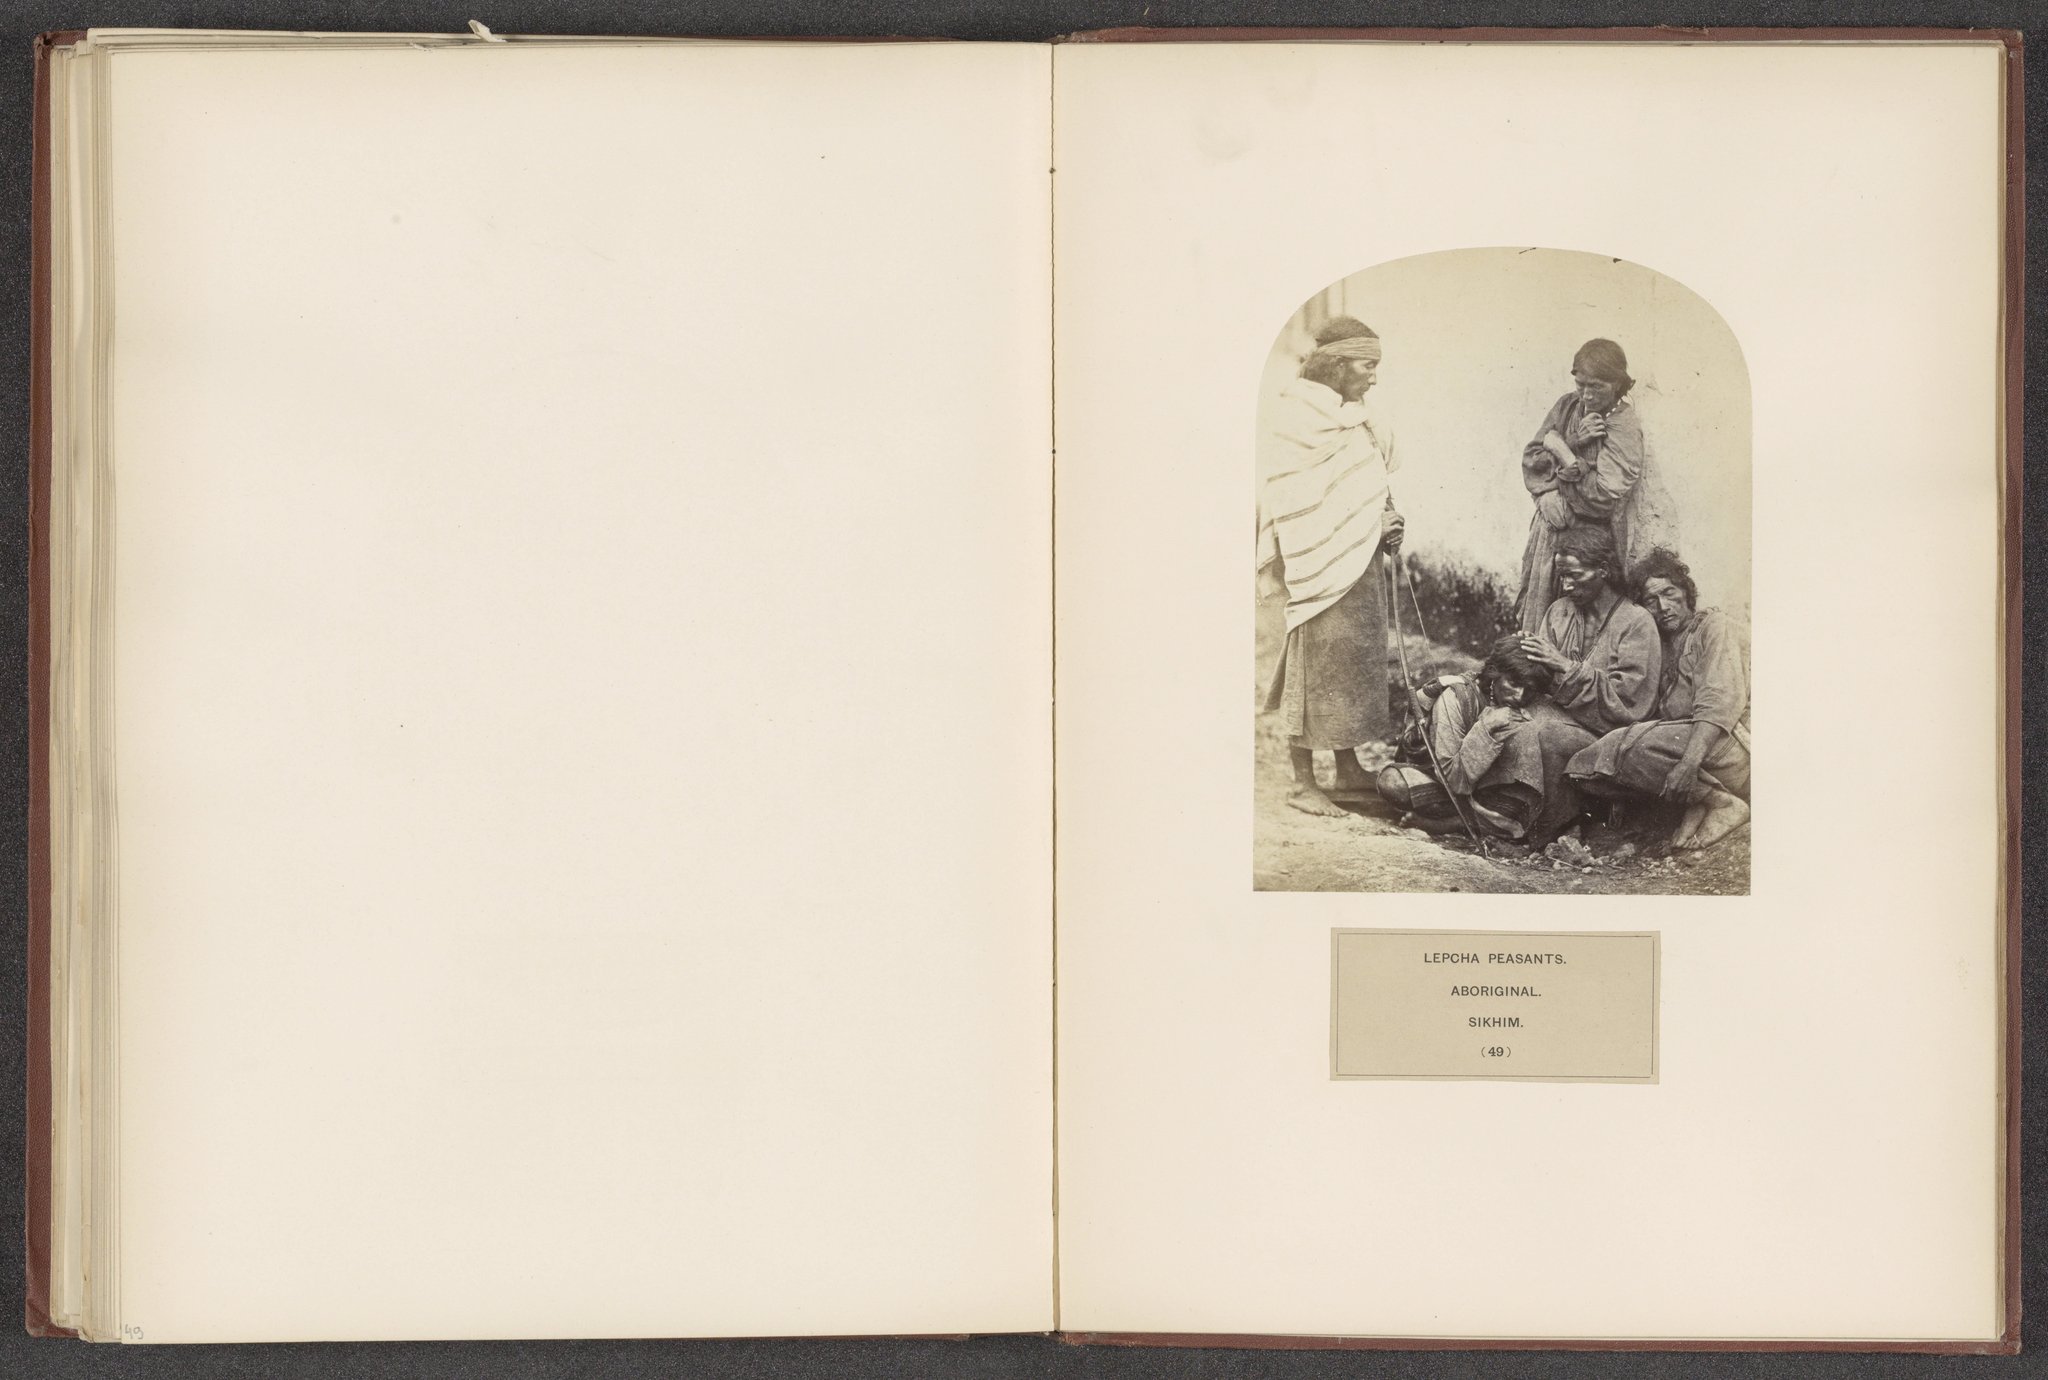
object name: page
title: Five unknown men on the street from the Lepcha community of Sikkim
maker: benjamin simpson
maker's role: fotograaf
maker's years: 1831-1923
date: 1858-1868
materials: photographic support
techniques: albumen print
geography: sikkim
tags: human races; peoples; nationalities, street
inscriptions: inscription: ‘LEPCHA PEASANTS./ ABORIGINAL./ SIKHIM.’, number: ‘(49)’